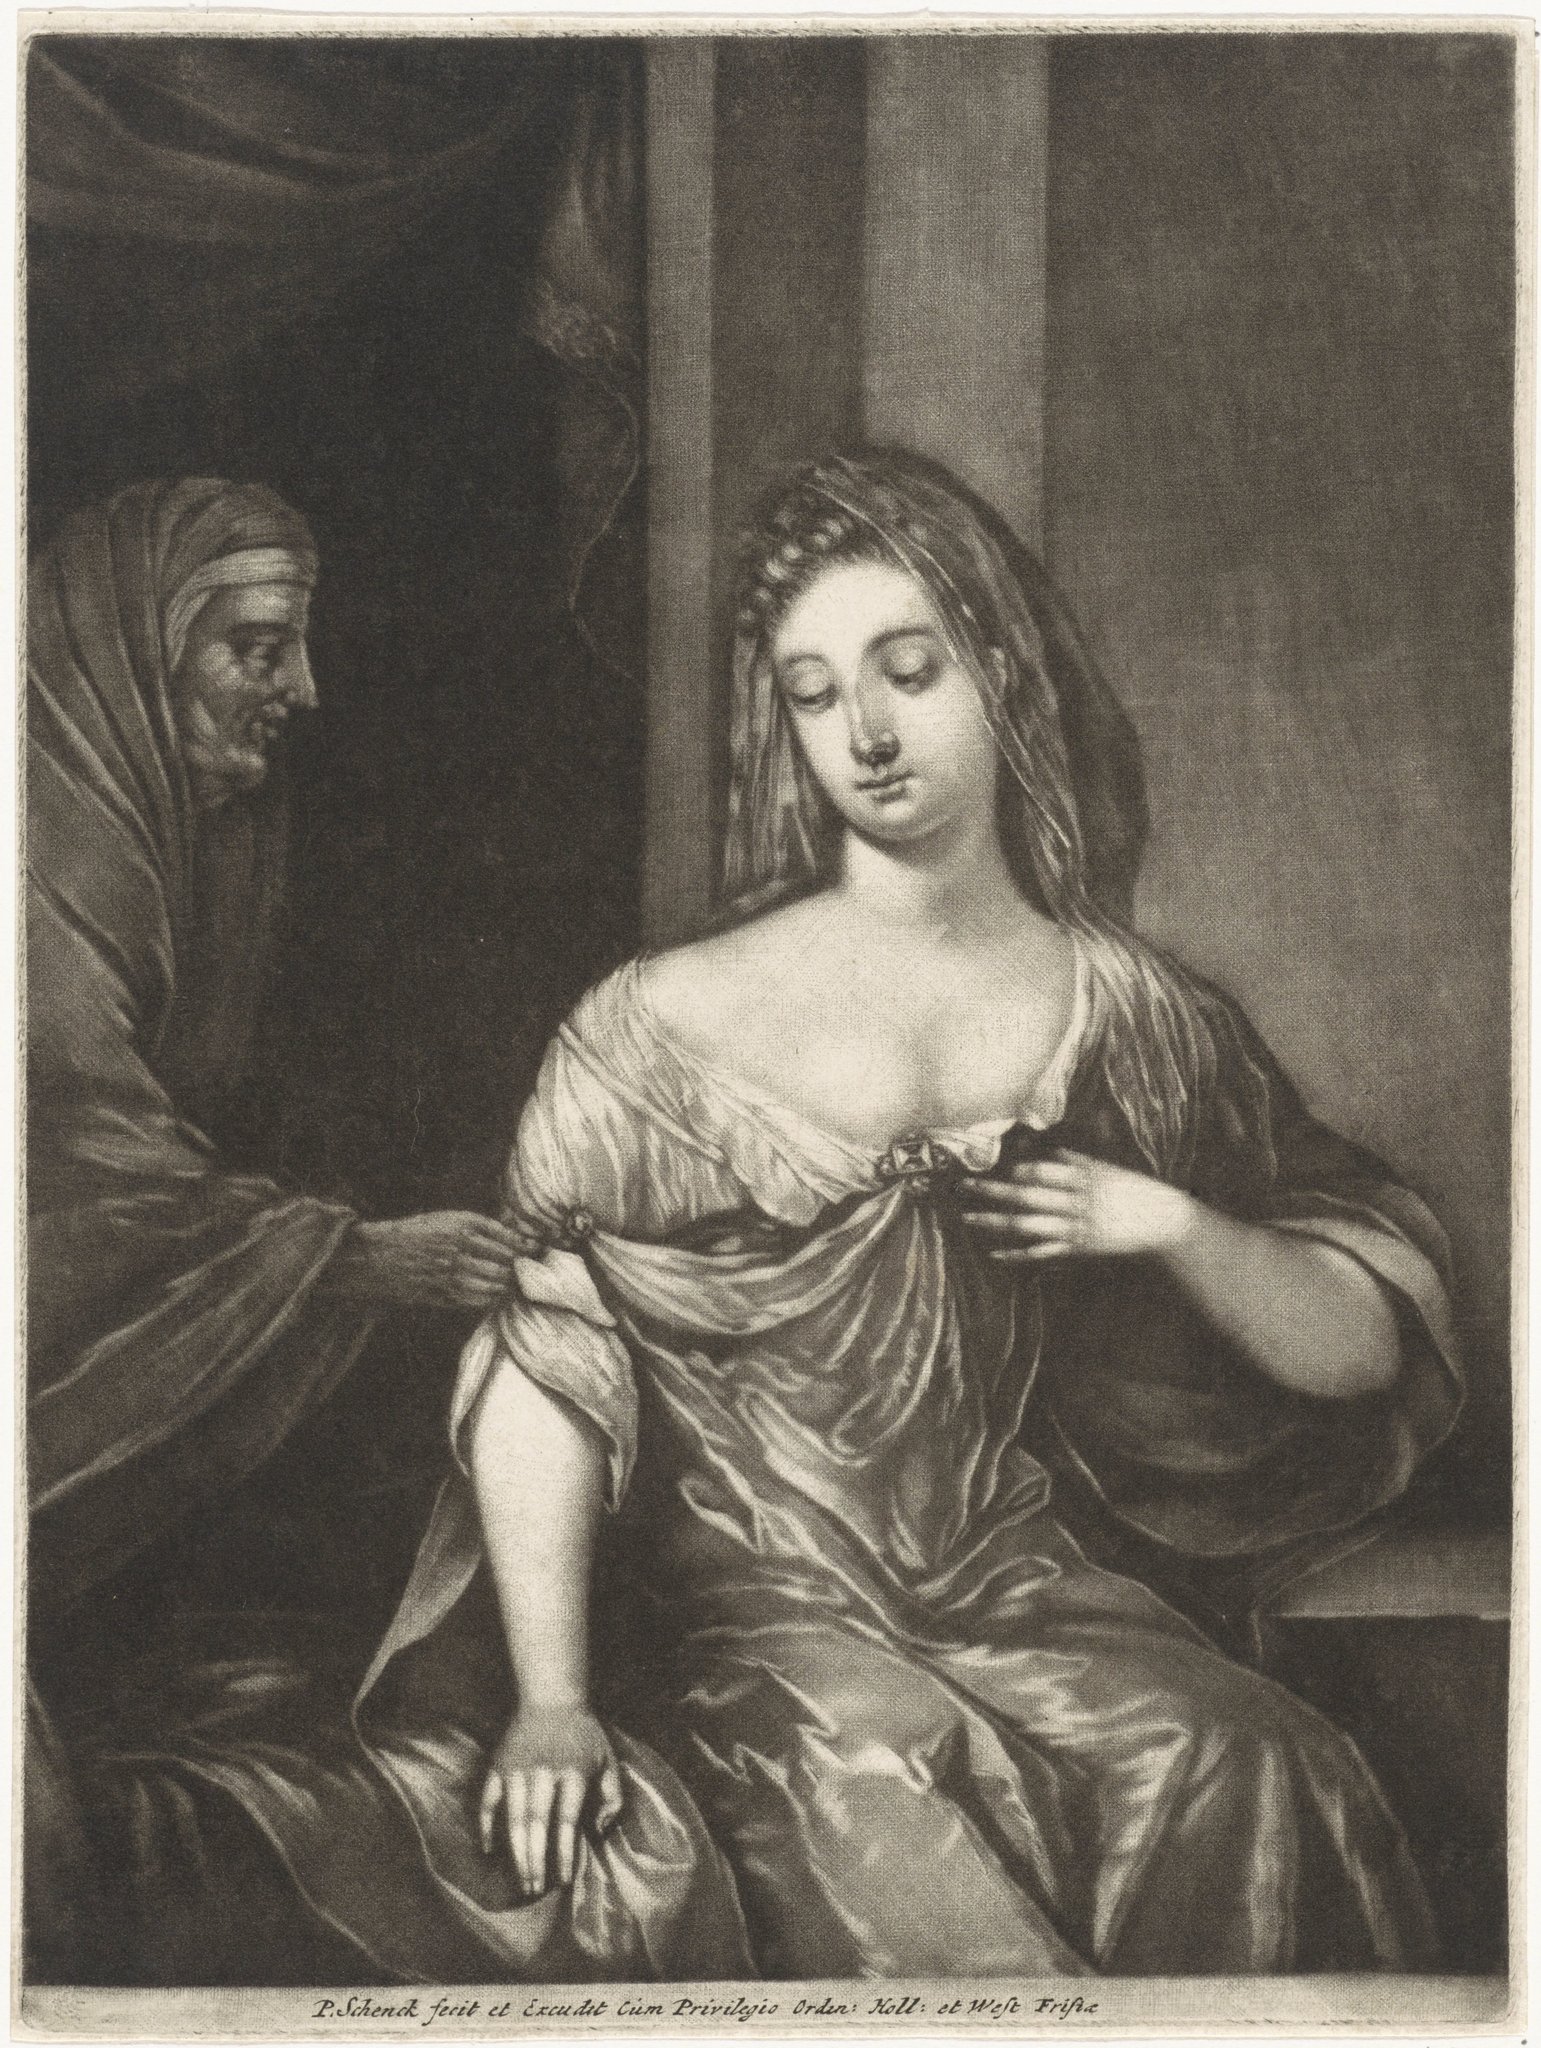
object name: print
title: Jonge vrouw ontvangt een briefje van een koppelaarster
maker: pieter schenk (i)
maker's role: print maker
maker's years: 1660-1711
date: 1670-1713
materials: paper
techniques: engraving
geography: amsterdam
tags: madam (brothel scene), letter, envelope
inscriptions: collector's mark: Lugt 2228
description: De prent in een pendant van "Jonge vrouw en een koppelaarster" van dezelfde prentmaker.